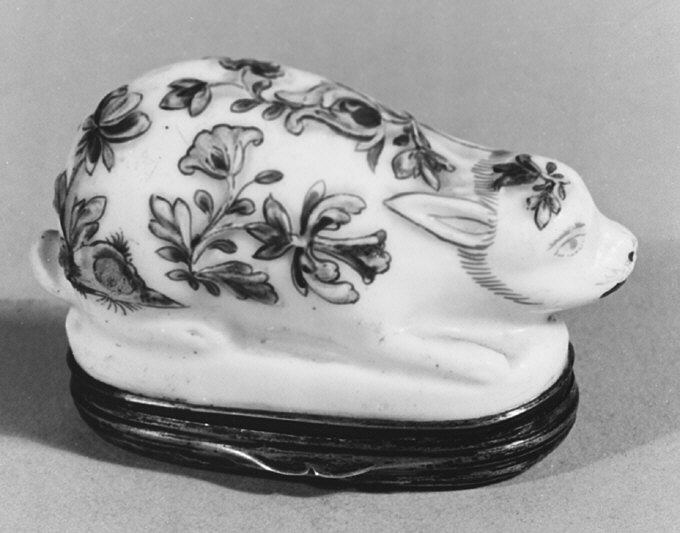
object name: snuffbox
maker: saint-cloud factory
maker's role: factory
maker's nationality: french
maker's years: 1693-1766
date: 1748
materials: silver, soft paste porcelain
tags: rabbits,flowers